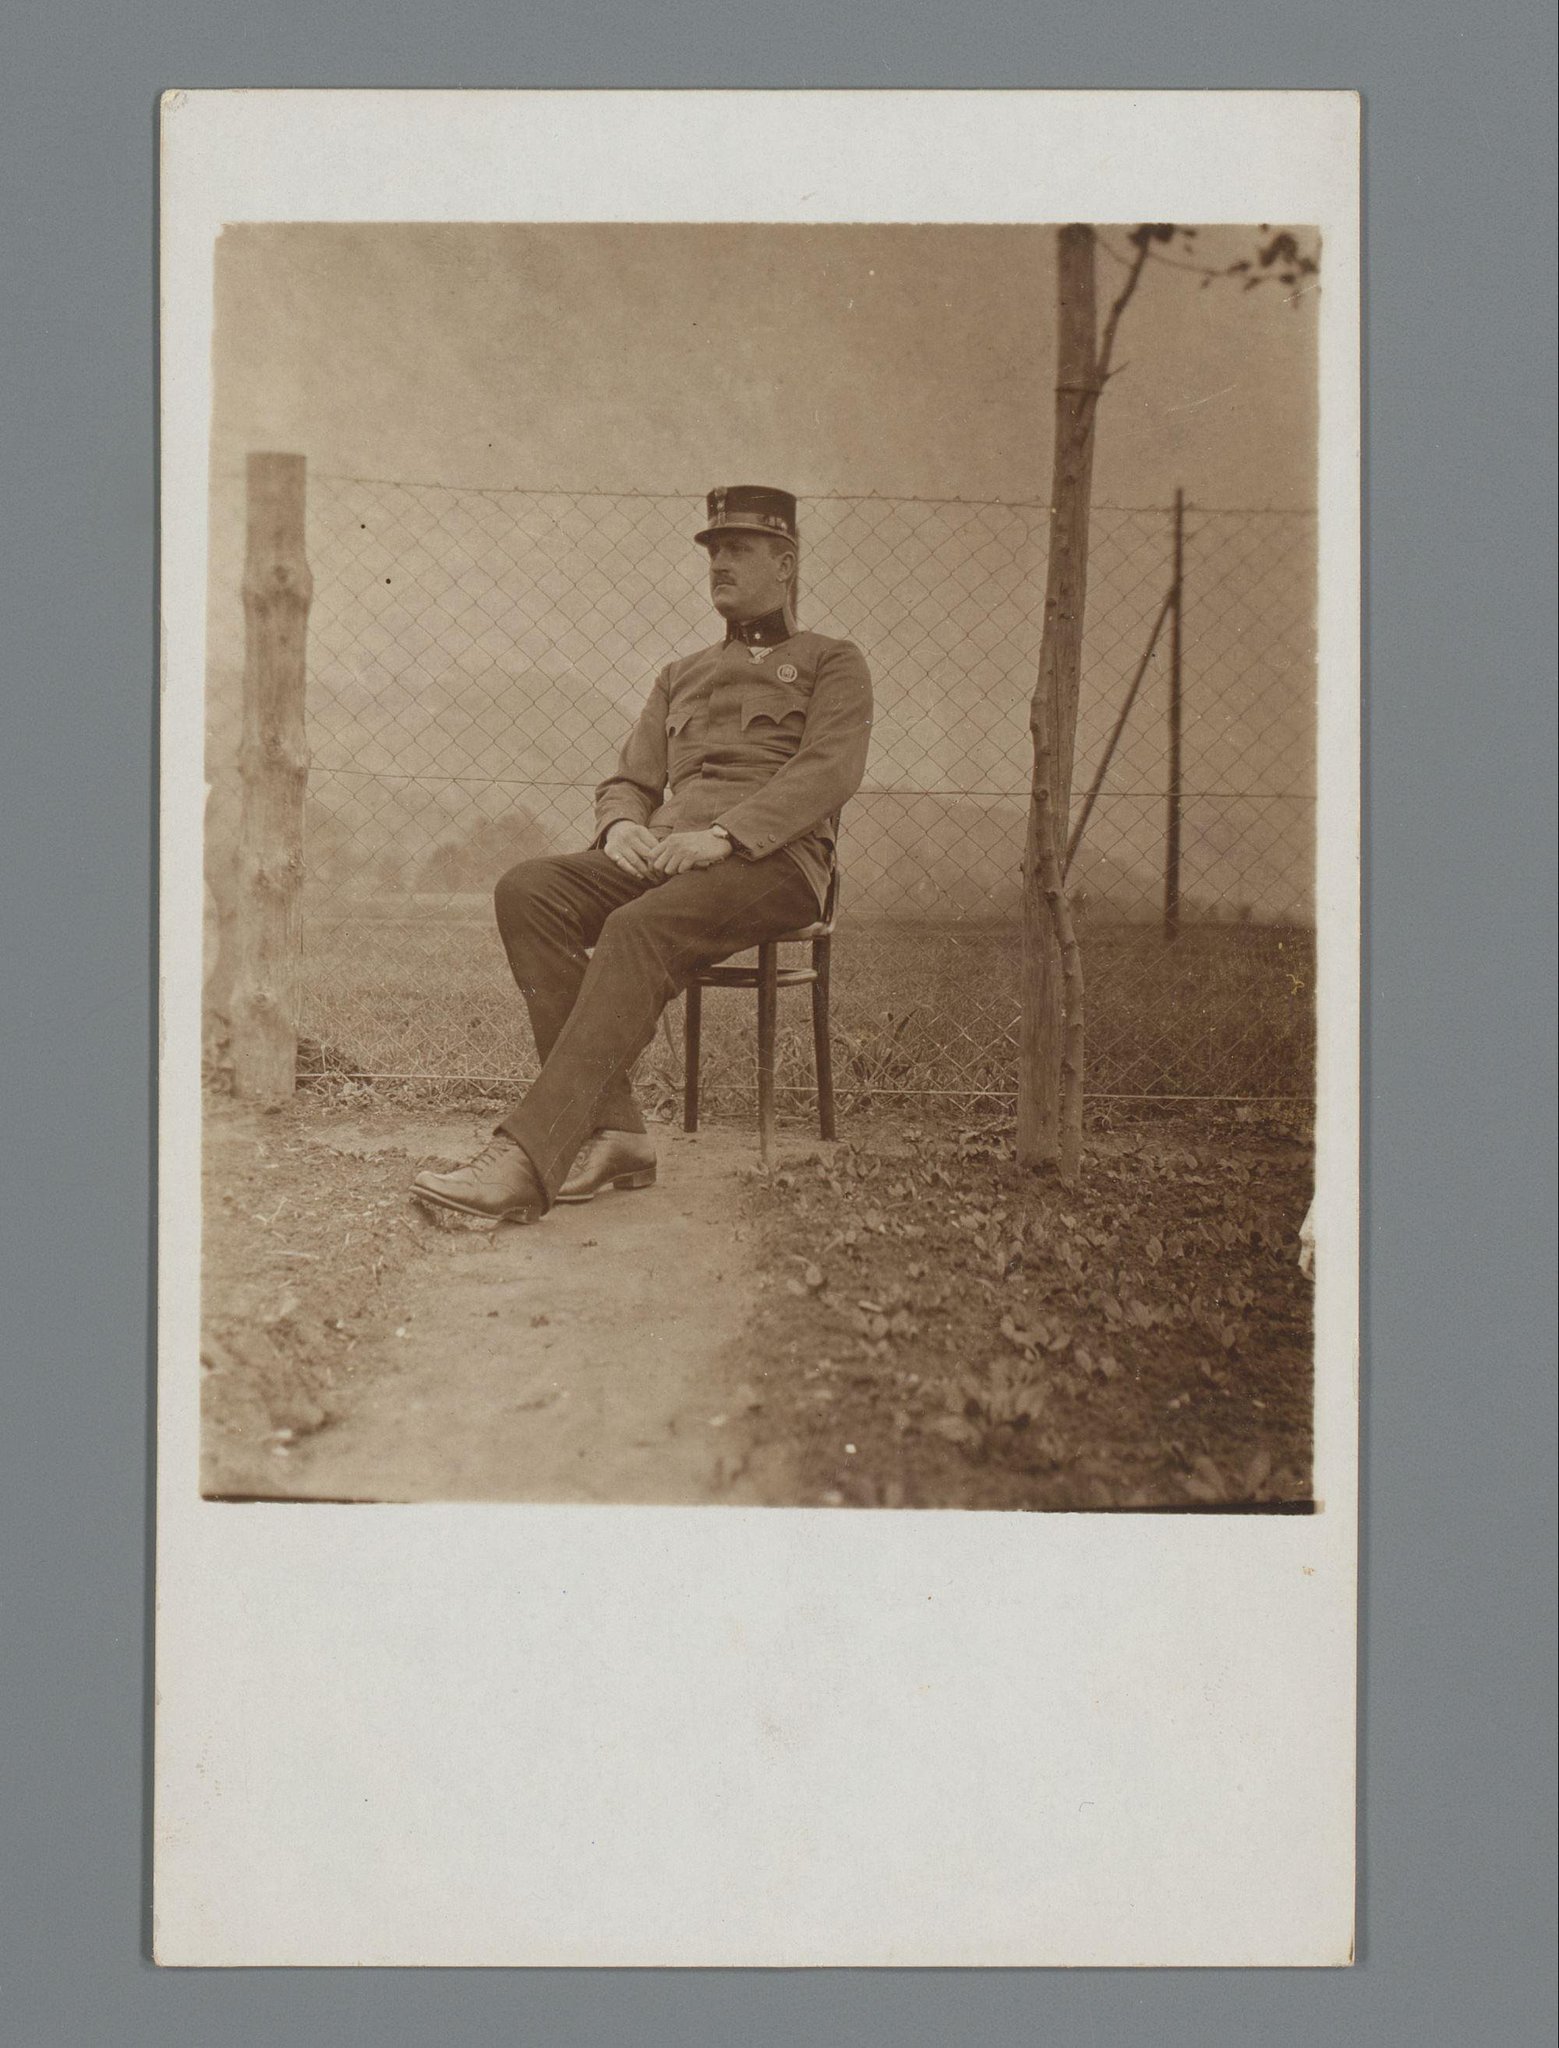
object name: photograph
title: Portret van een onbekende man in uniform buiten op een stoel, vermoedelijk een wachter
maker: Anonymous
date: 1895-1920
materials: paper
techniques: collodion silver print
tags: waiting, watching, adult man, anonymous historical person portrayed, (military) uniforms